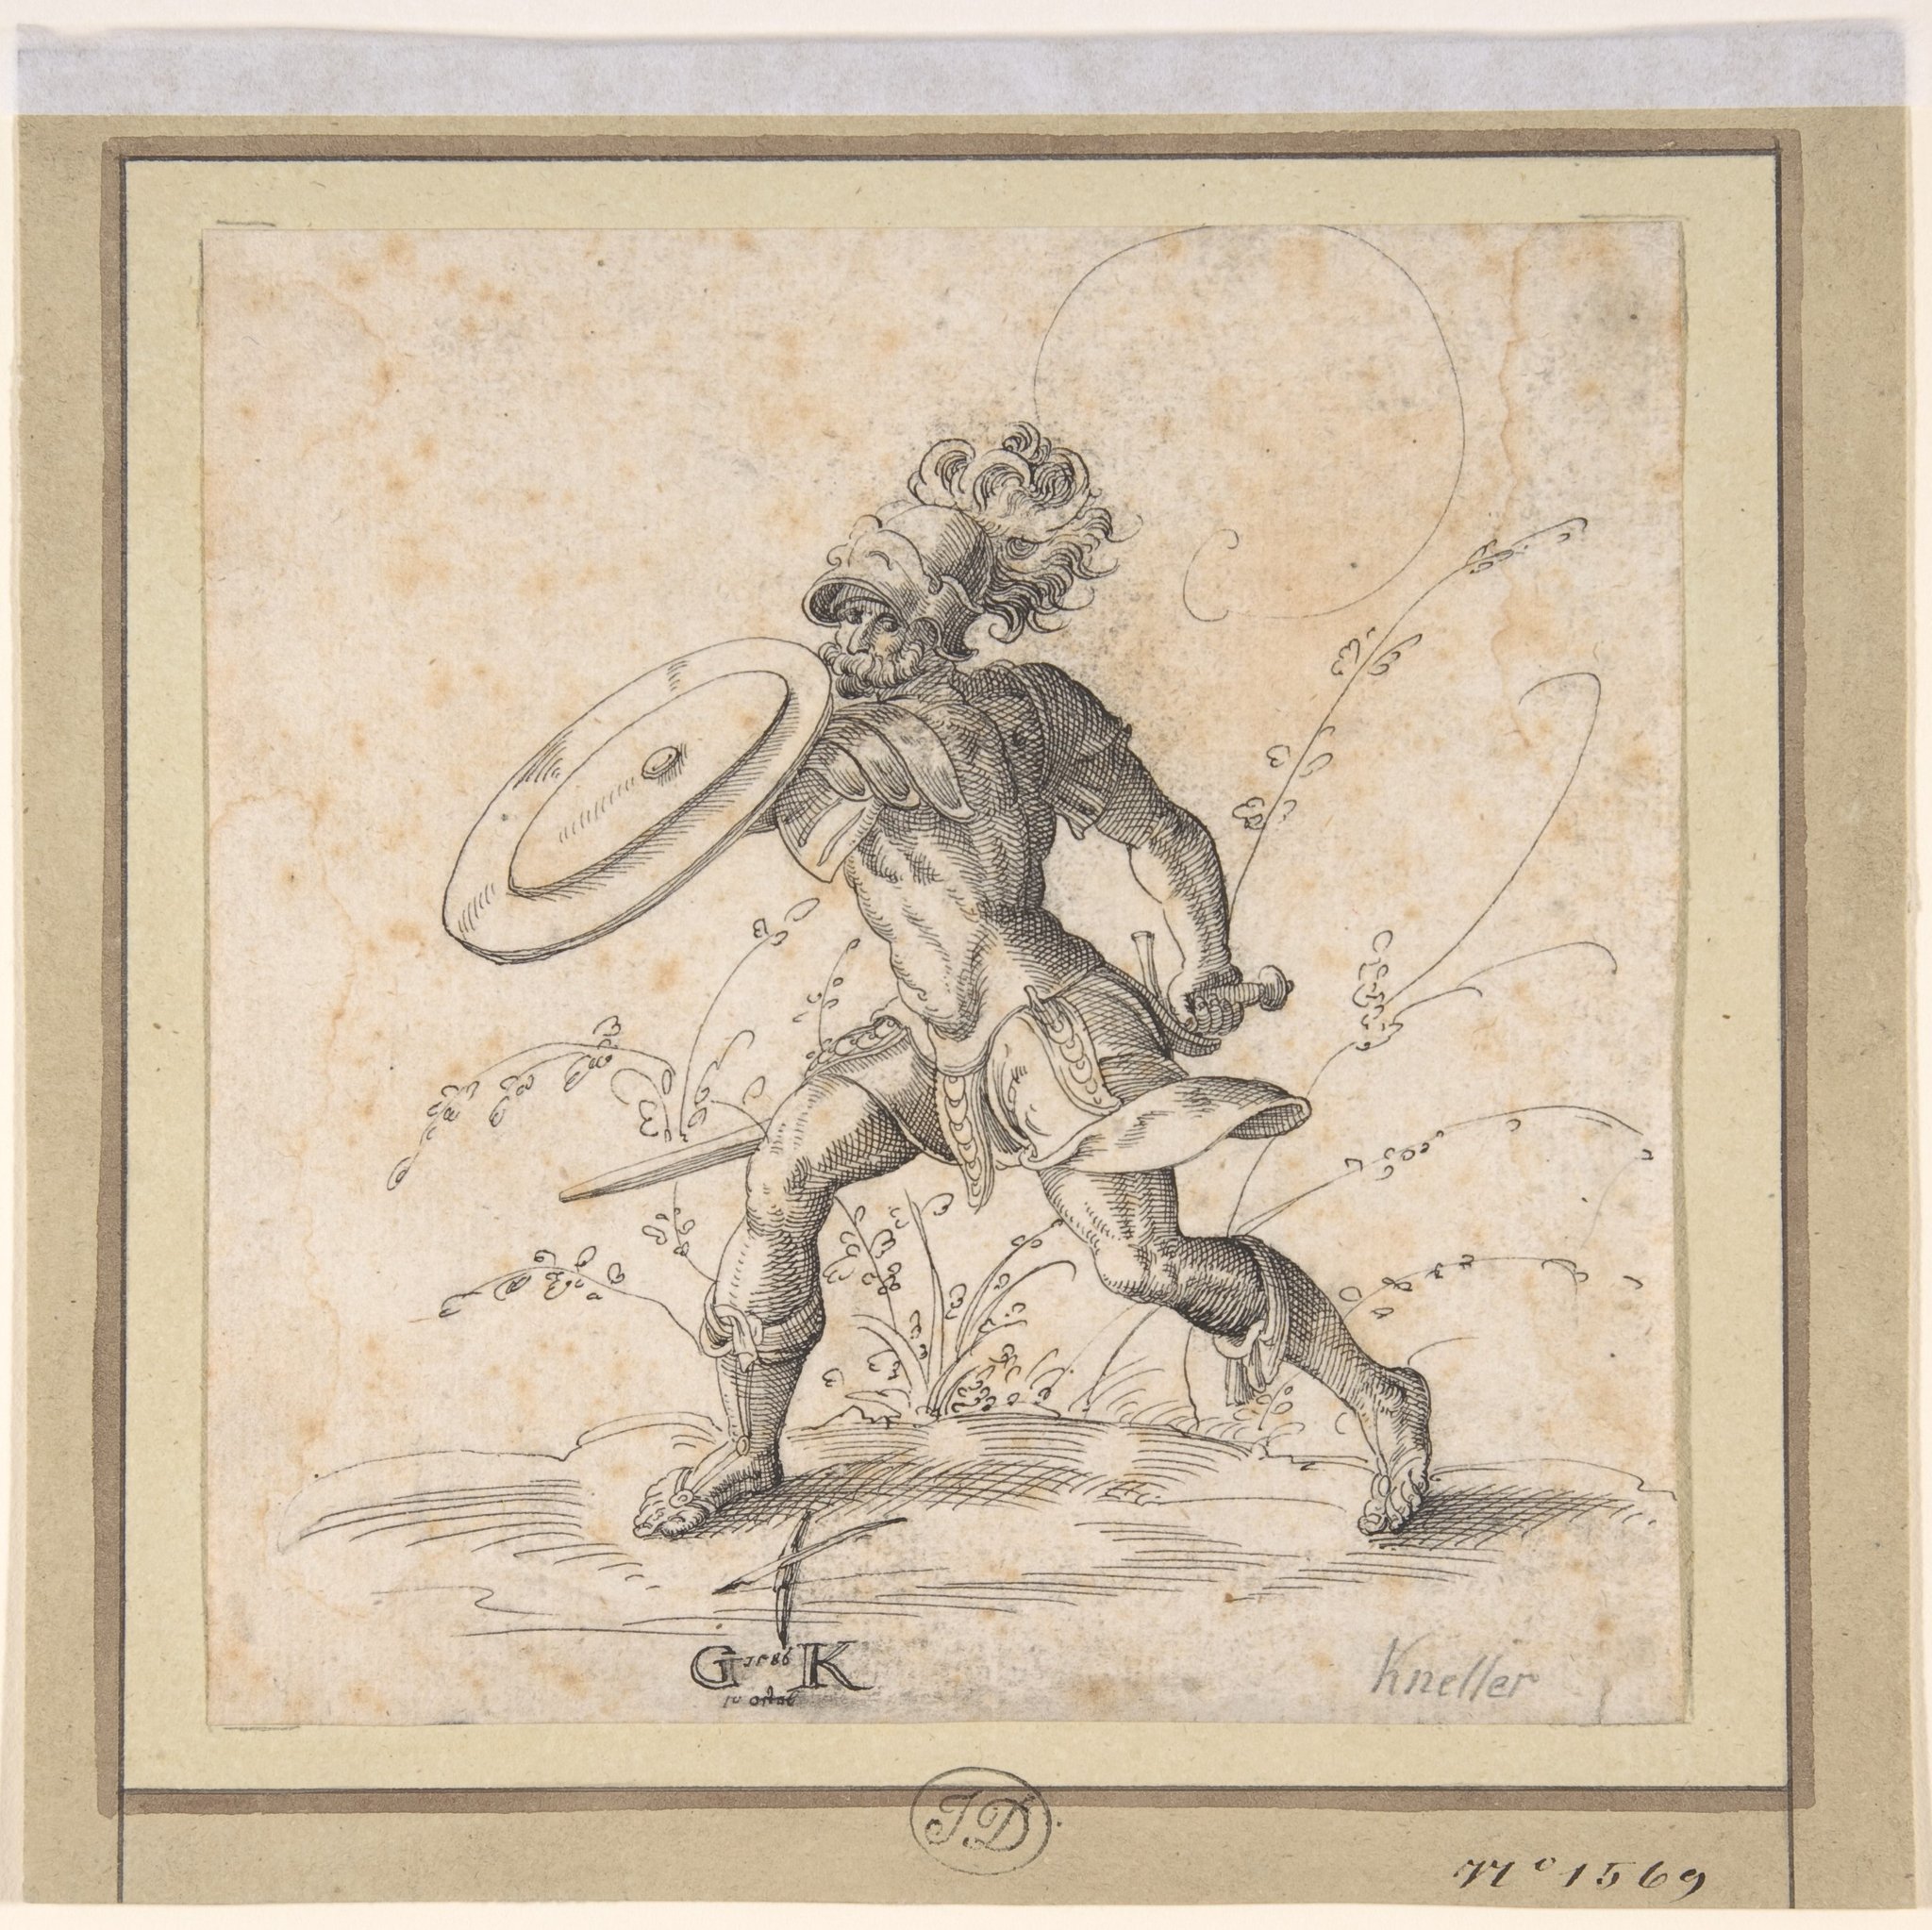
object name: drawing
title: A Soldier Brandishing a Shield in a Landscape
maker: monogrammist gk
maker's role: artist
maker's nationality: german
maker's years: 16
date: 1586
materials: ink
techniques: pen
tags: soldiers,shields,swords,men